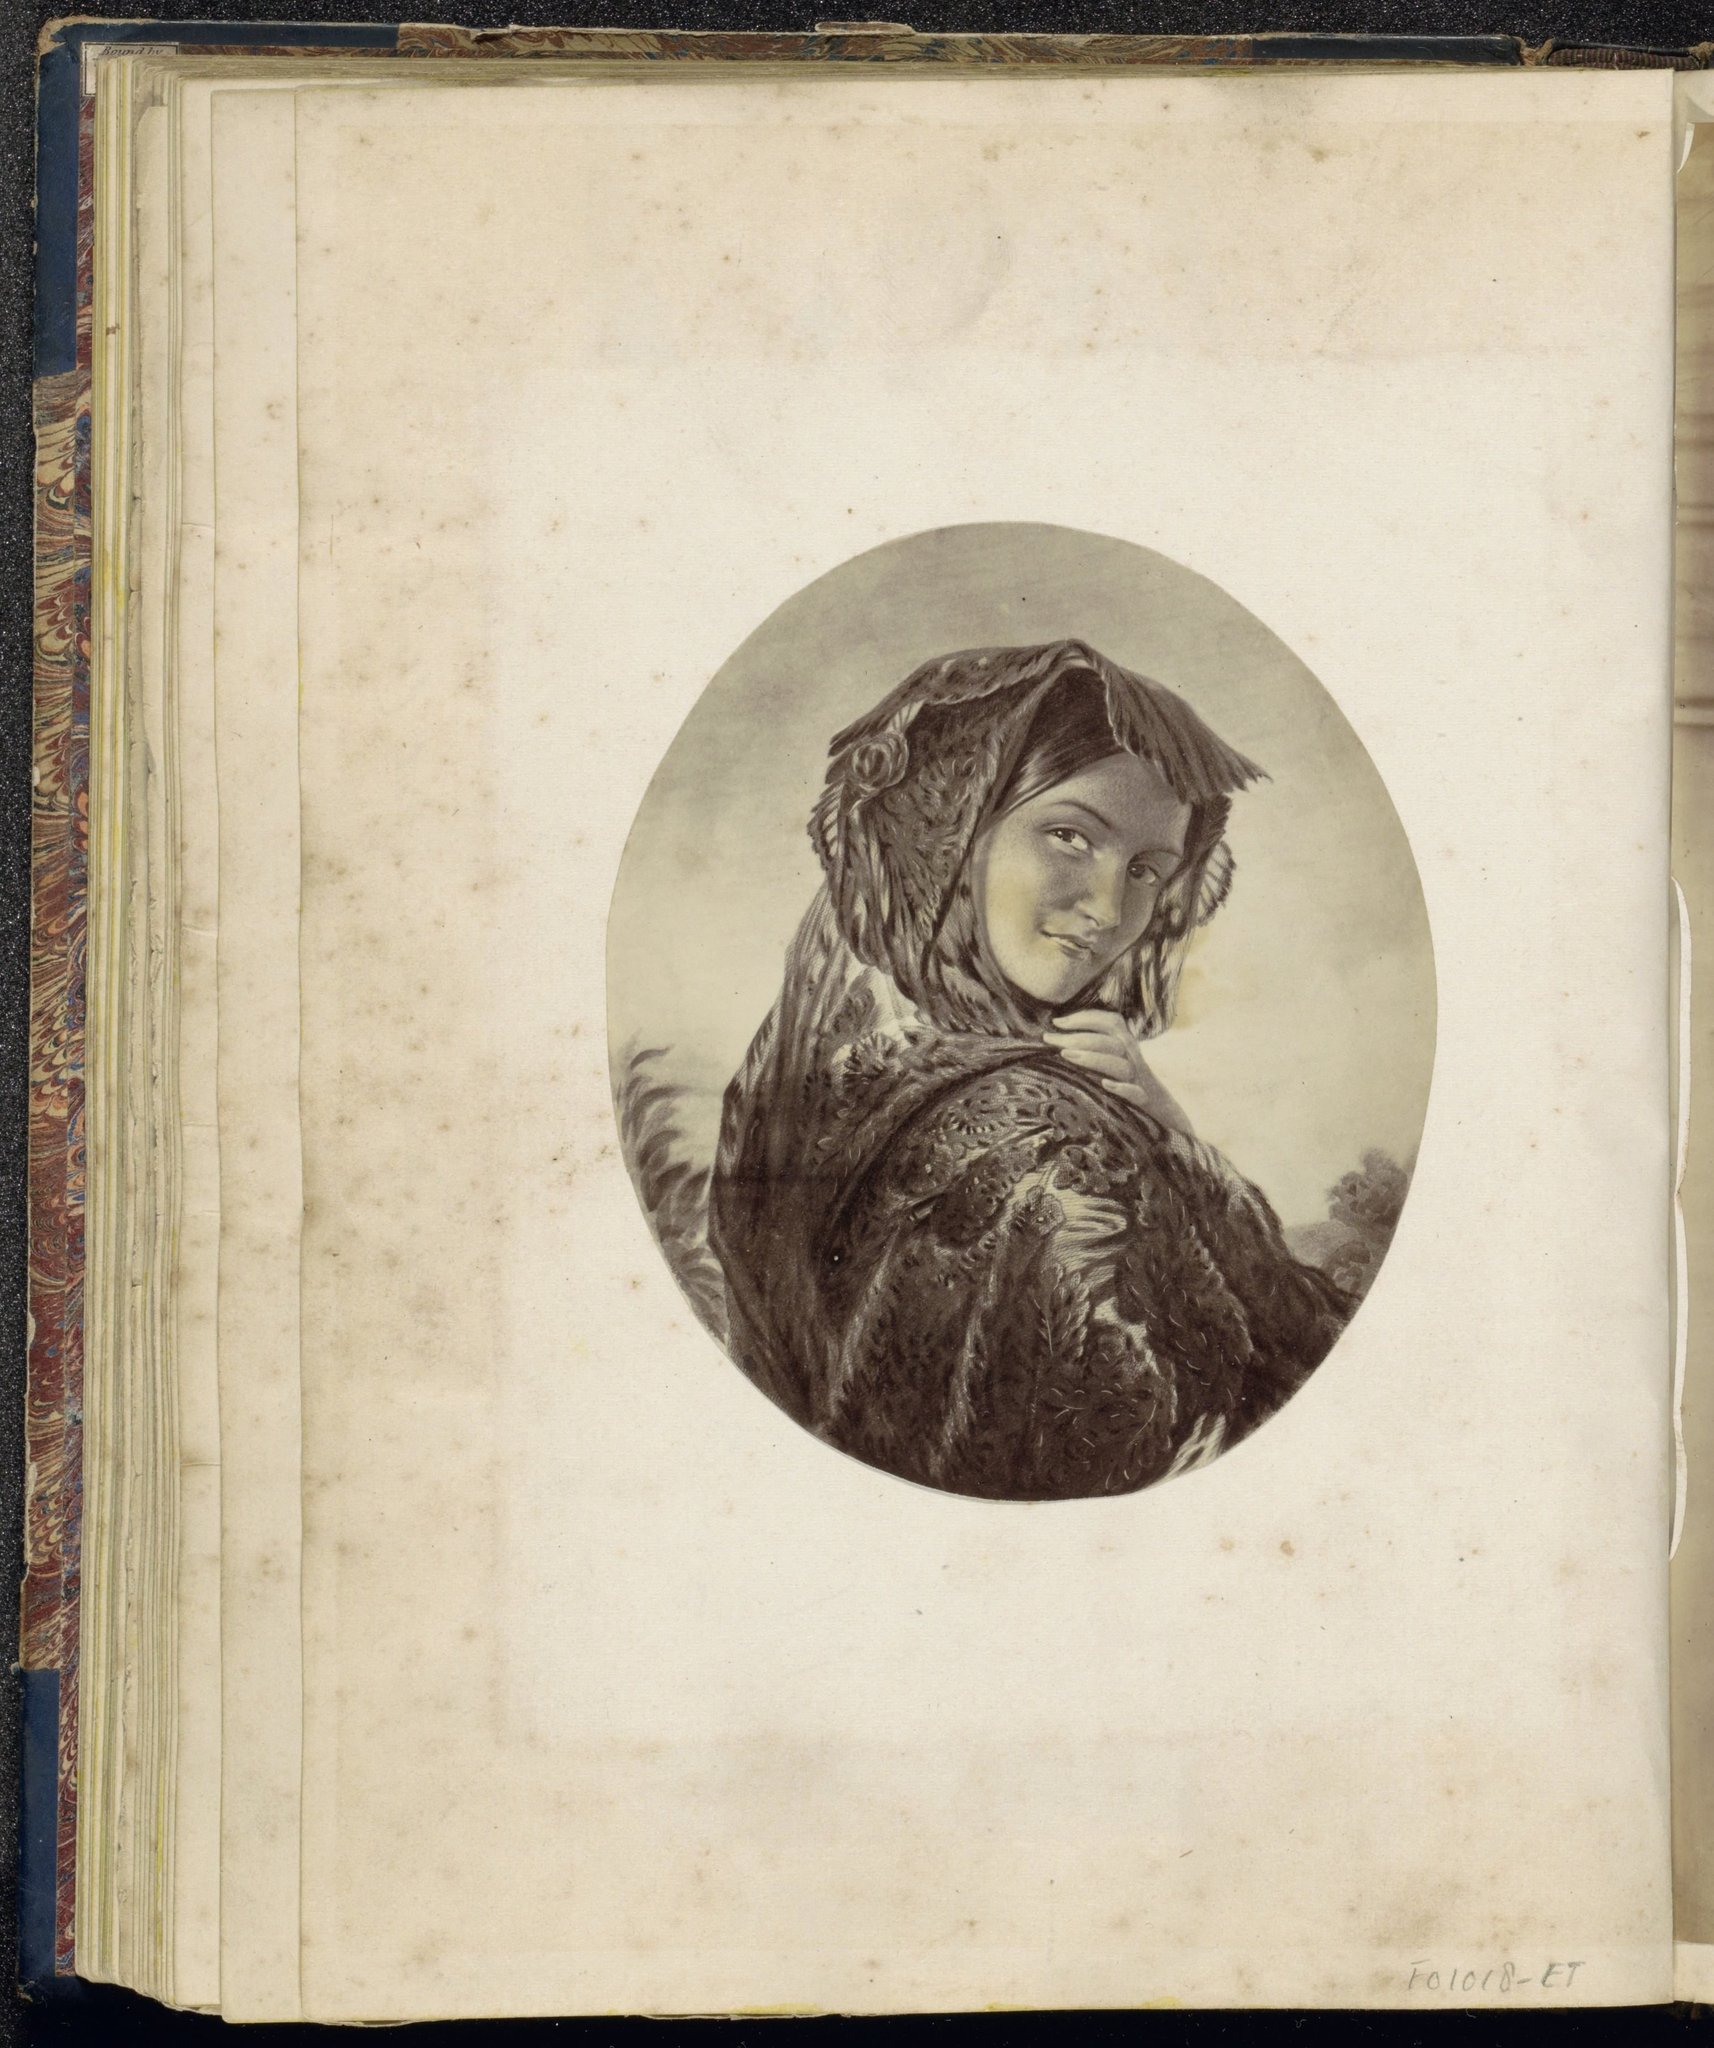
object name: reproduction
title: Fotoreproductie van (vermoedelijk) een schilderij met een gehoofddoekte jonge vrouw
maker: Anonymous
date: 1860-1870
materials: paper, photographic support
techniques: albumen print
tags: adolescent, young woman, maiden, head-gear (with name)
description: Onderdeel van Engels familiealbum met foto's van personen, reizen, cricket en kunstwerken.